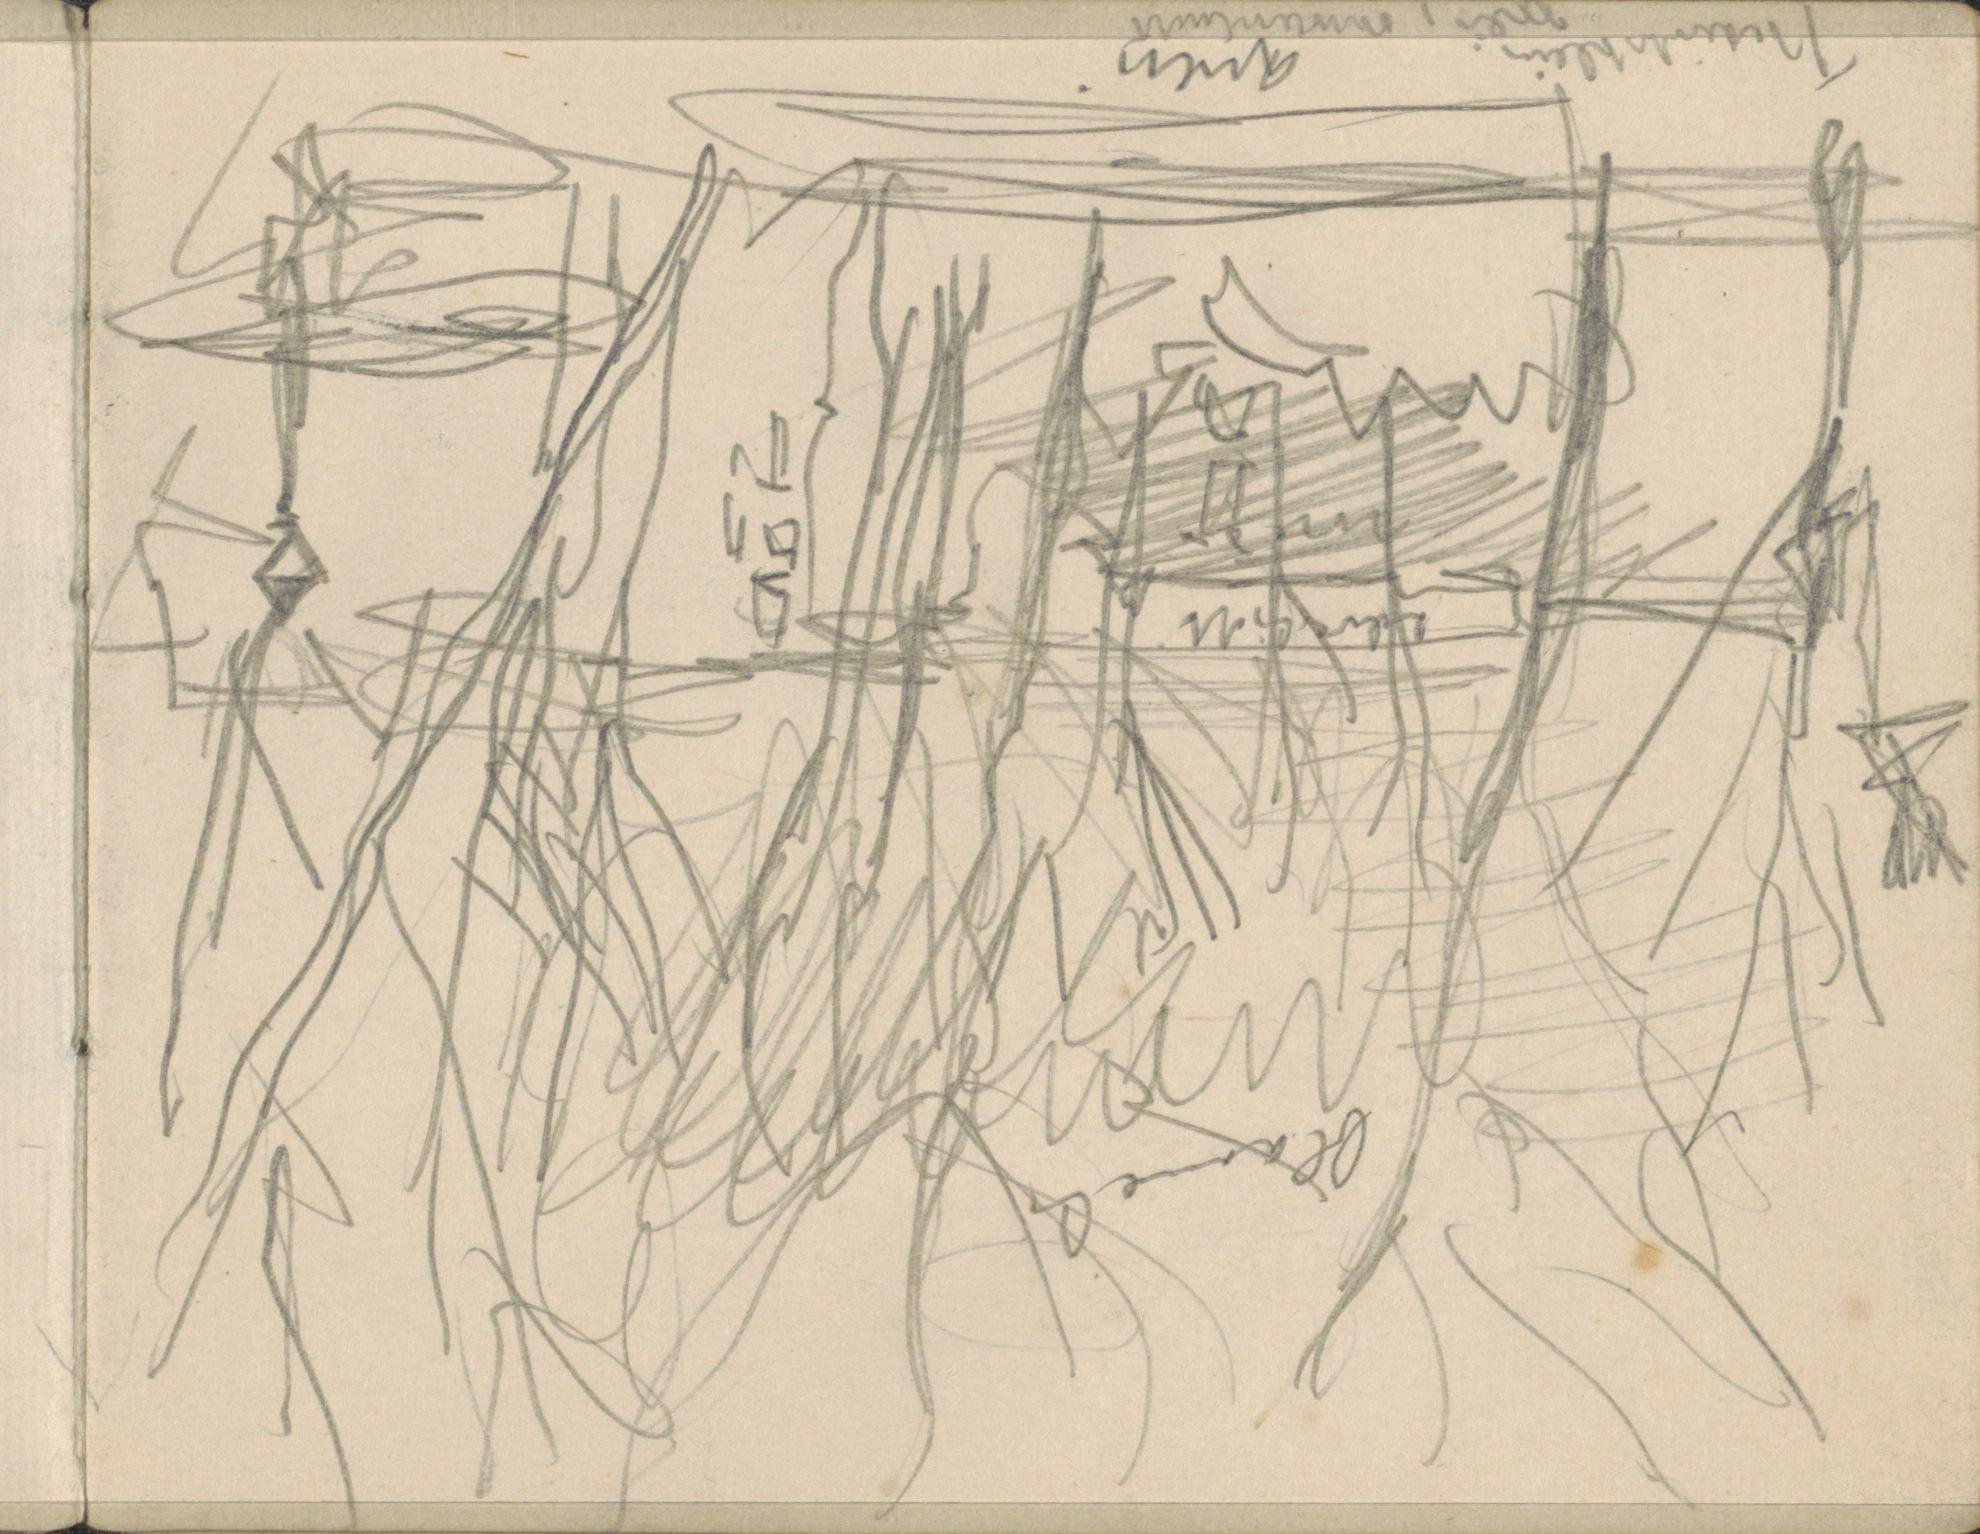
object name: sketchbook leaf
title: Gezicht op het Frederiksplein te Amsterdam bij avond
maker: george hendrik breitner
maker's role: draughtsman, painter, print maker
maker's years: 1857-1923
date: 1886-1895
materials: paper, pencil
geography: amsterdam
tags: square, place, circus, etc., civic architecture; edifices; dwellings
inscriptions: annotation: ‘Frederiksplein/ mei, onweerslucht’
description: Pagina 28 uit een schetsboek met 34 bladen.